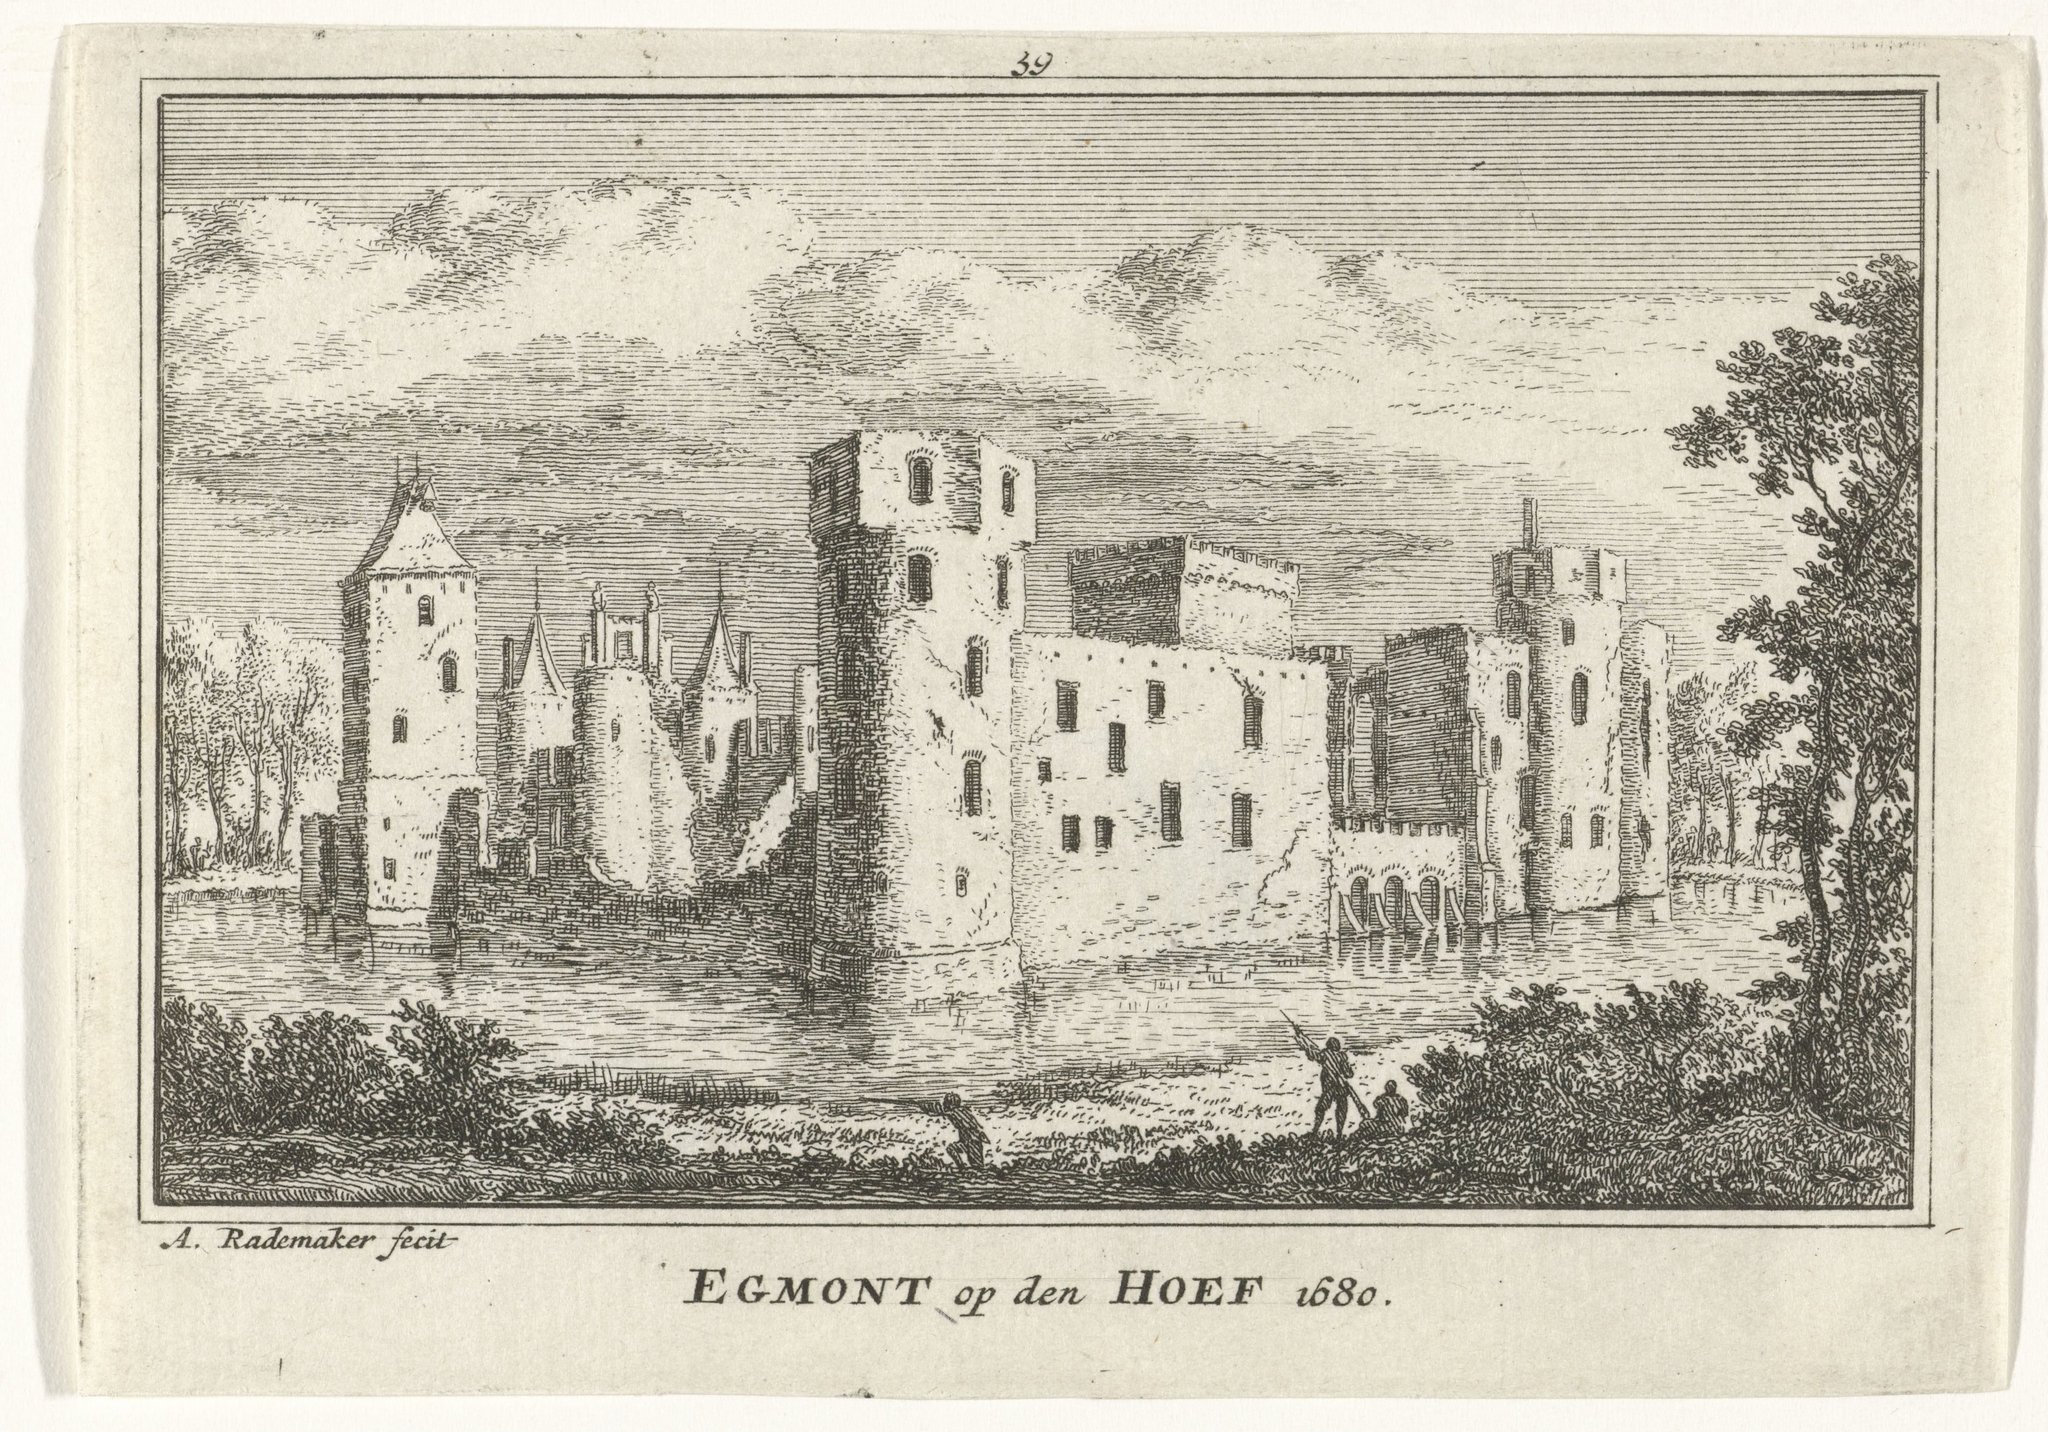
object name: print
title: Egmont op den Hoef 1680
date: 1727-1733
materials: paper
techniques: etching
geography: amsterdam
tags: castle, hunter, ruin of a dwelling, house, castle, etc.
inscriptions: collector's mark: Lugt 2228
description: Illustratie uit: Abraham Rademaker, Matthaeus Brouërius van Niedek, Isaac Le Long, Kabinet van Nederlandsche en Kleefsche outheden en (...) voorname stads- en landgebouwen, Willem Barents en Antoni Schoonenburg: Amsterdam, 1727-1733, ill. nr. 39.